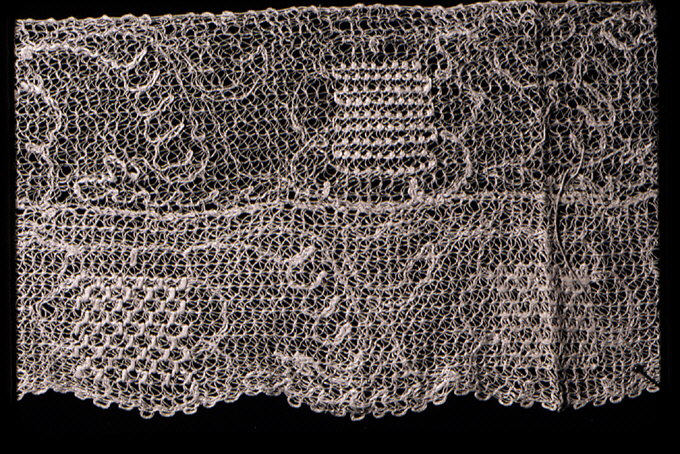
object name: lace strip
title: Two strips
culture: south american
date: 1701-1800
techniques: embroidery